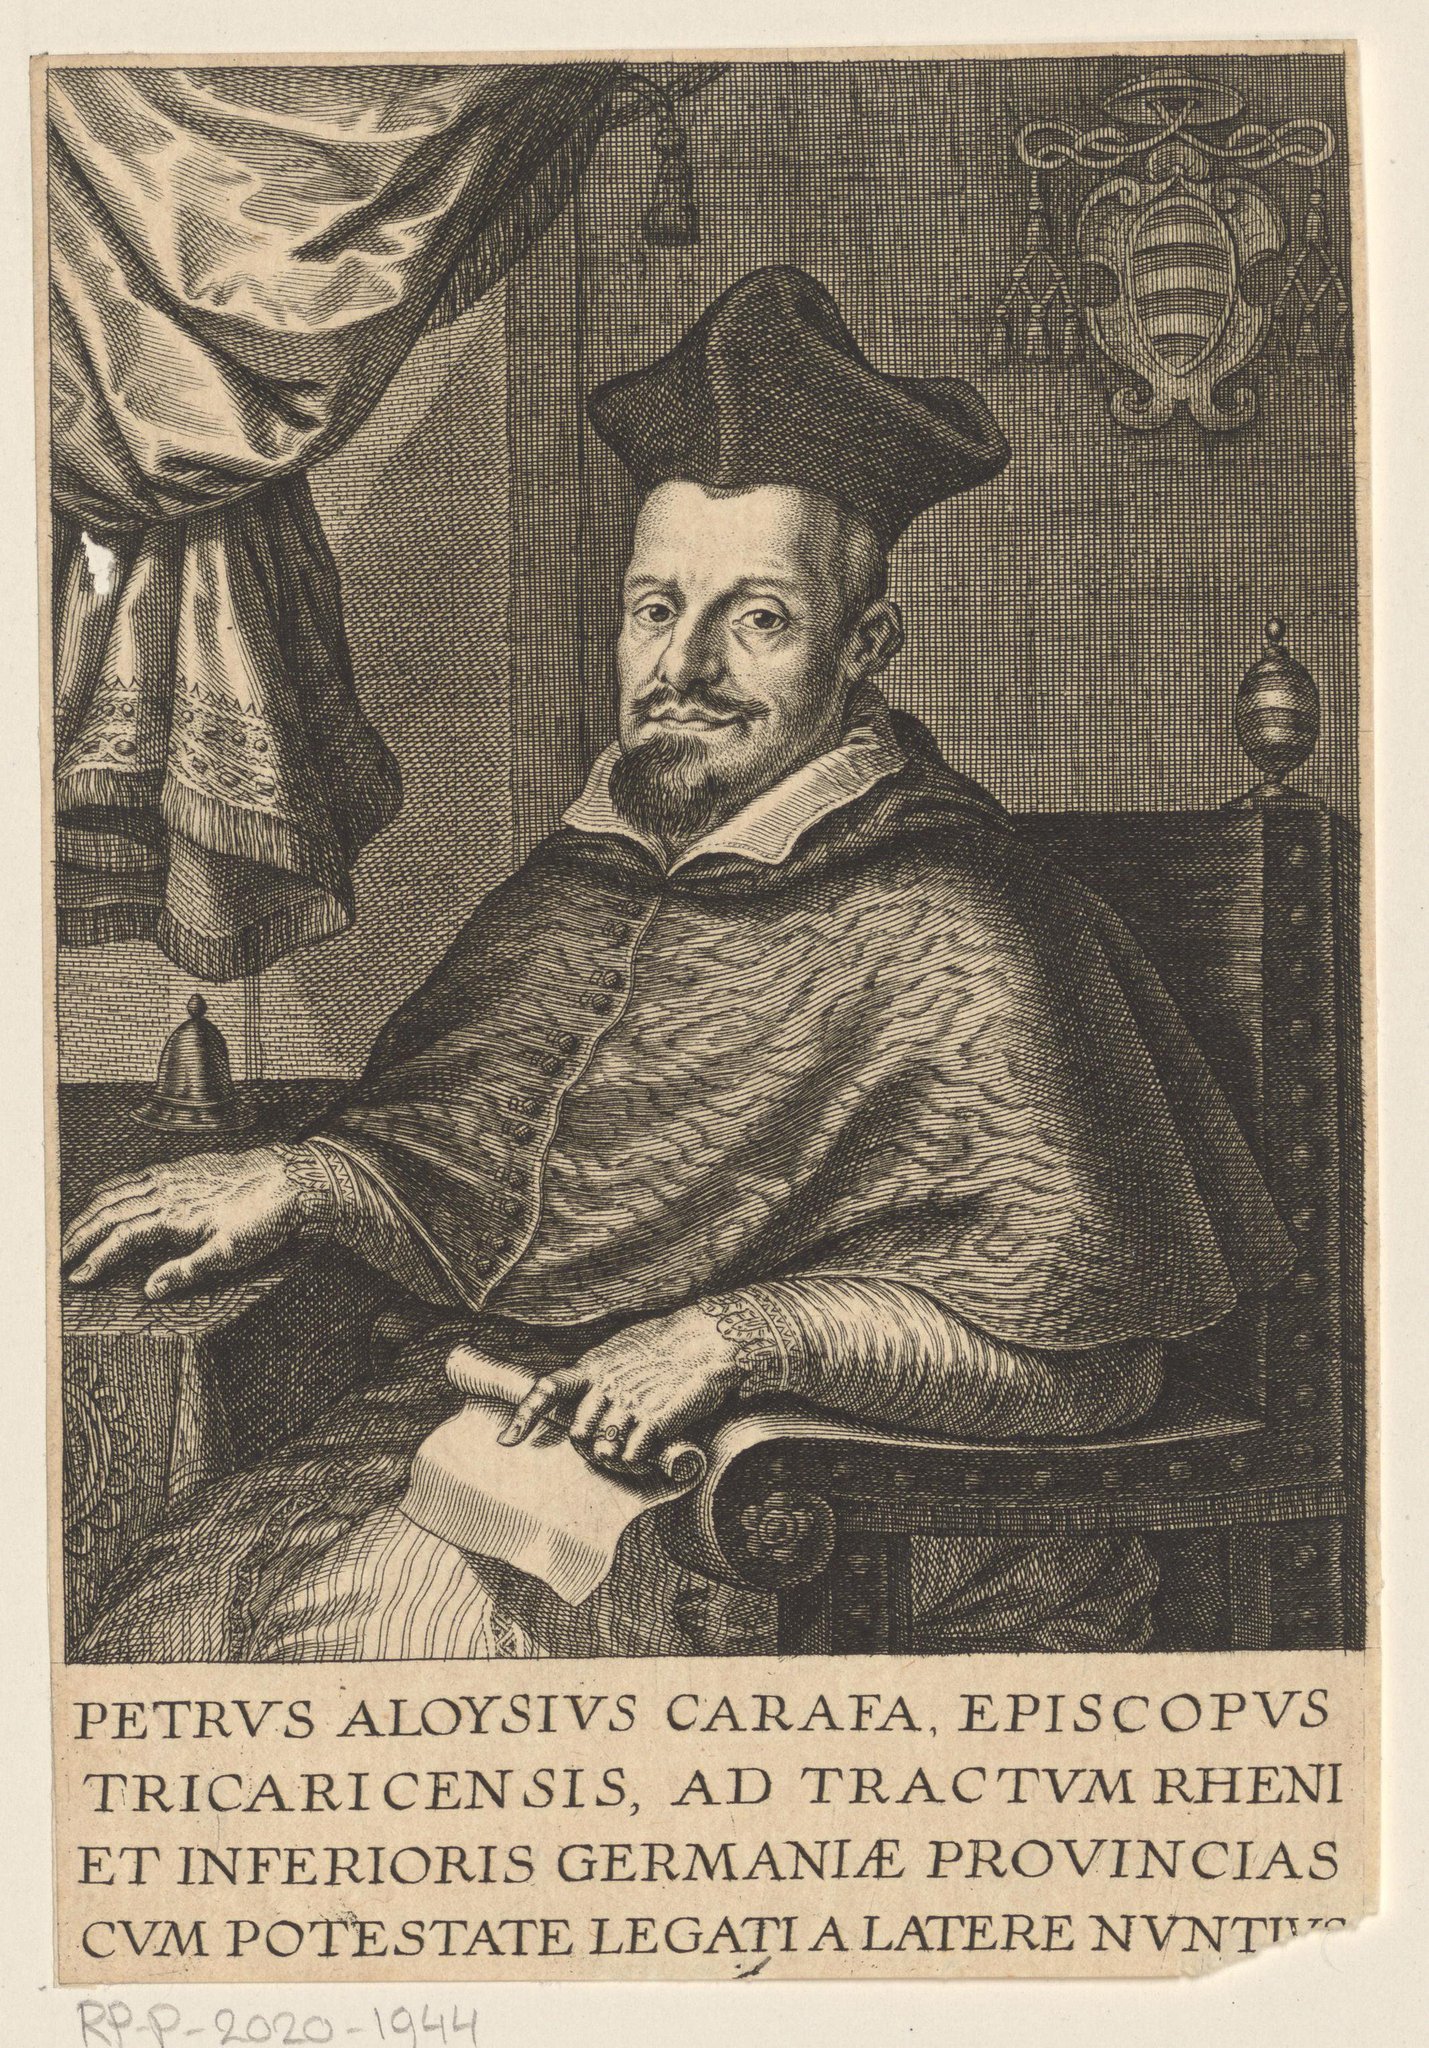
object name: print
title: Portret van Pierluigi Carafa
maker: Anonymous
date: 1630-1682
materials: paper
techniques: engraving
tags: naples, rome, historical persons, armorial bearing, heraldry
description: Prent met tekst op verso voor het eerst verschenen in: Pietrasanta, Silvestro. De symbolis heroicis libri IX. Antwerpen: Officina Plantiniana Balthasaris Moreti, 1630. Ook gebruikt in latere publicaties (1682).